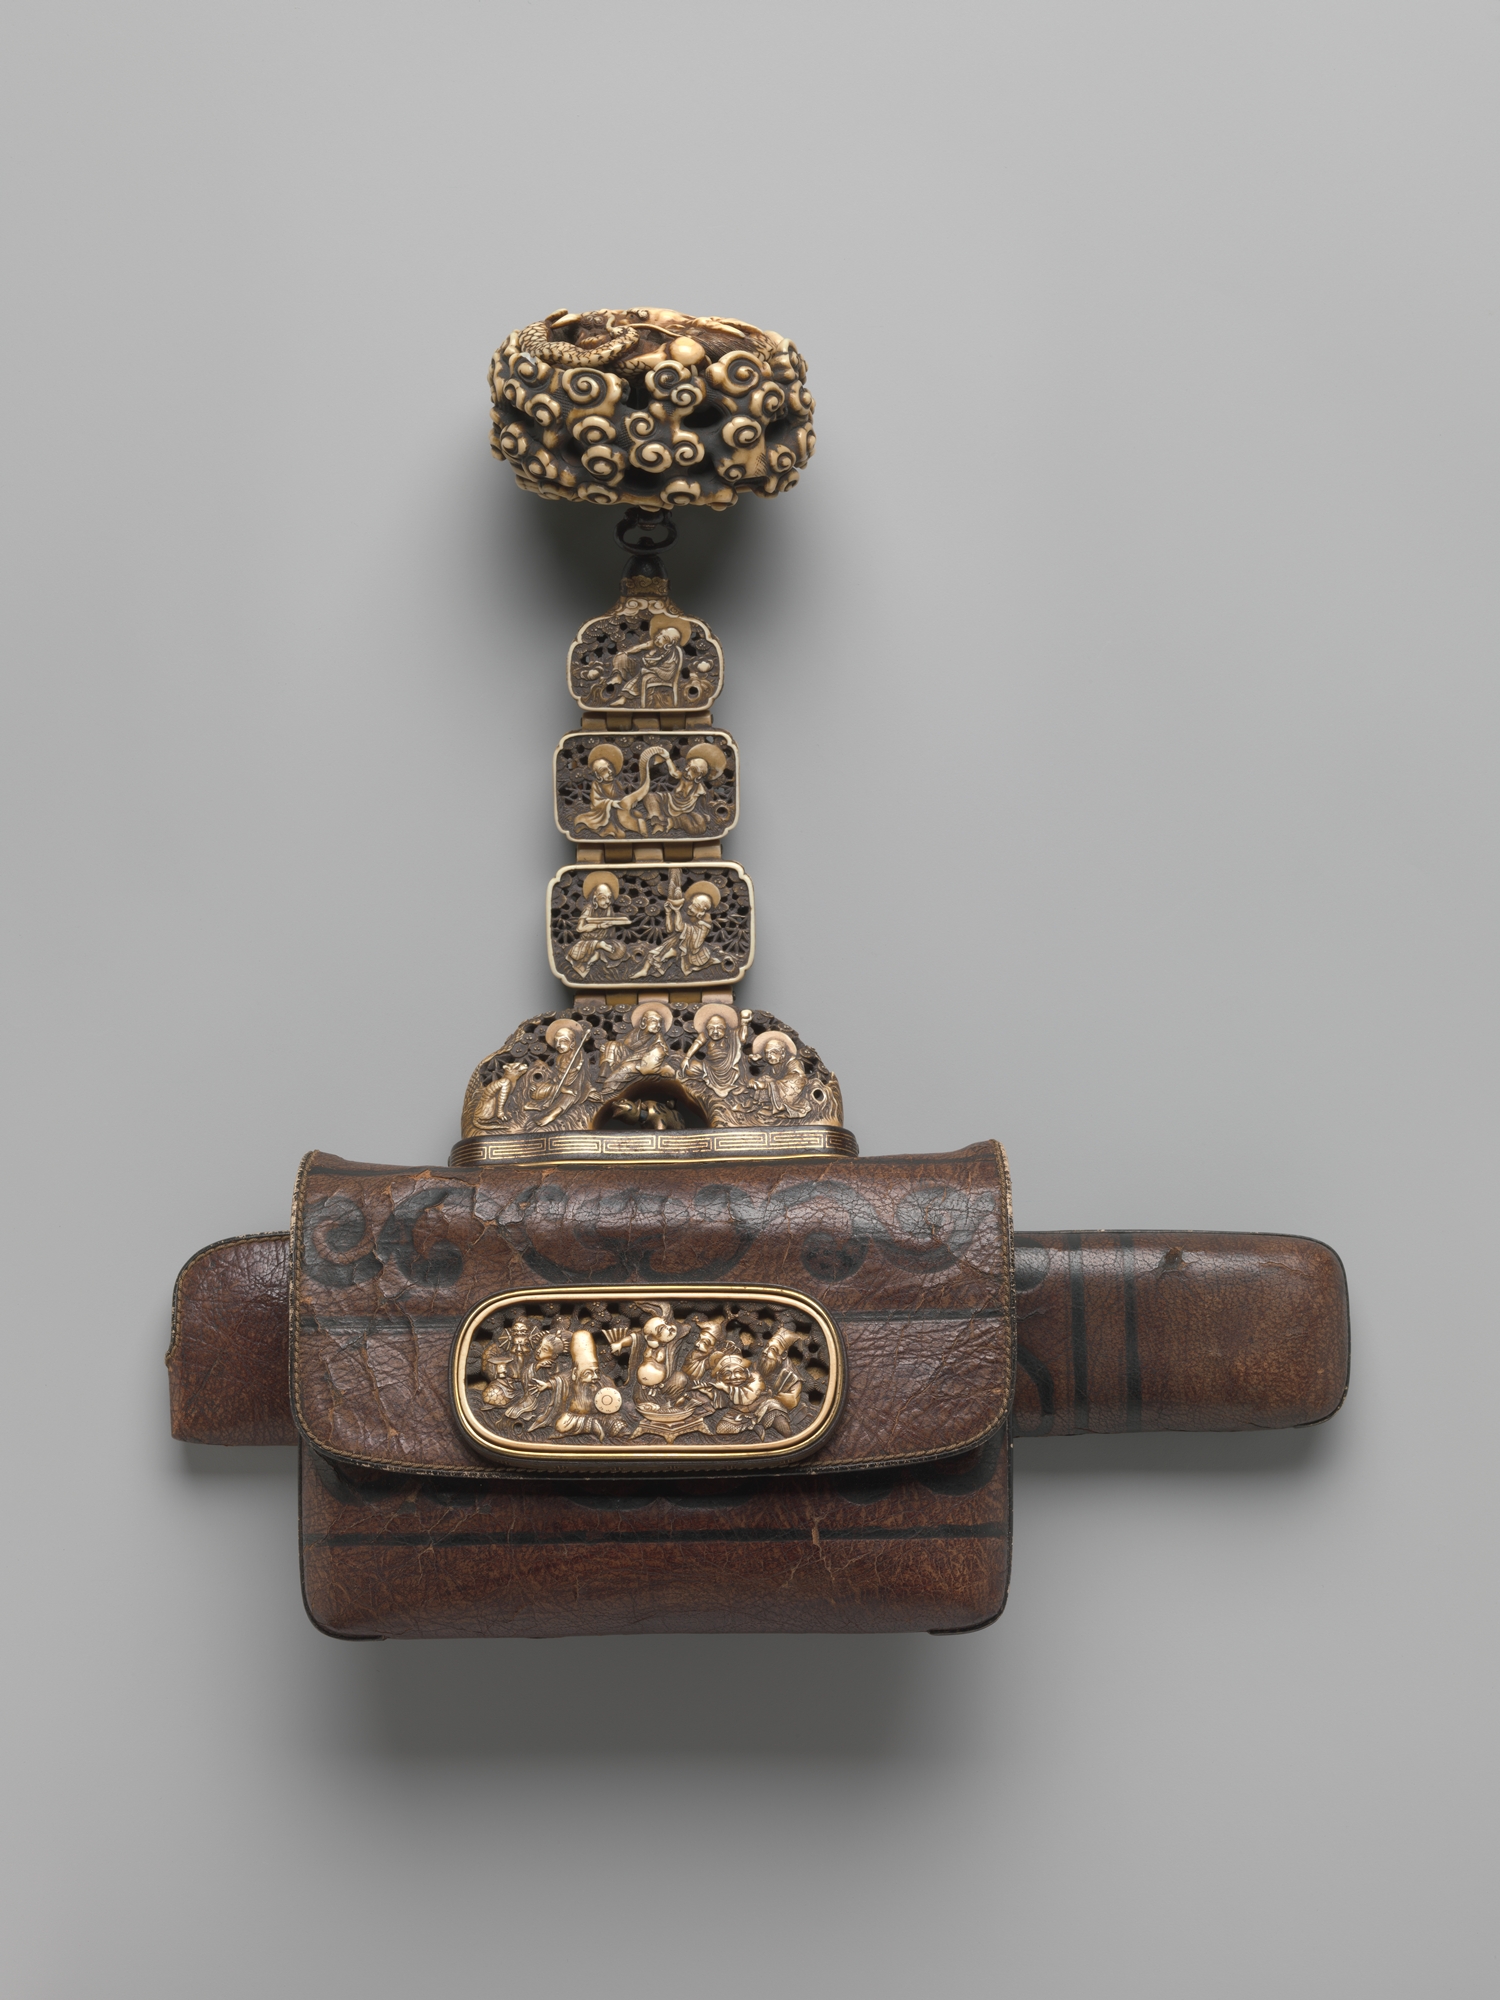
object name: tobacco pouch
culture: japanese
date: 1701-1800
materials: gold, ivory, leather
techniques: embossing